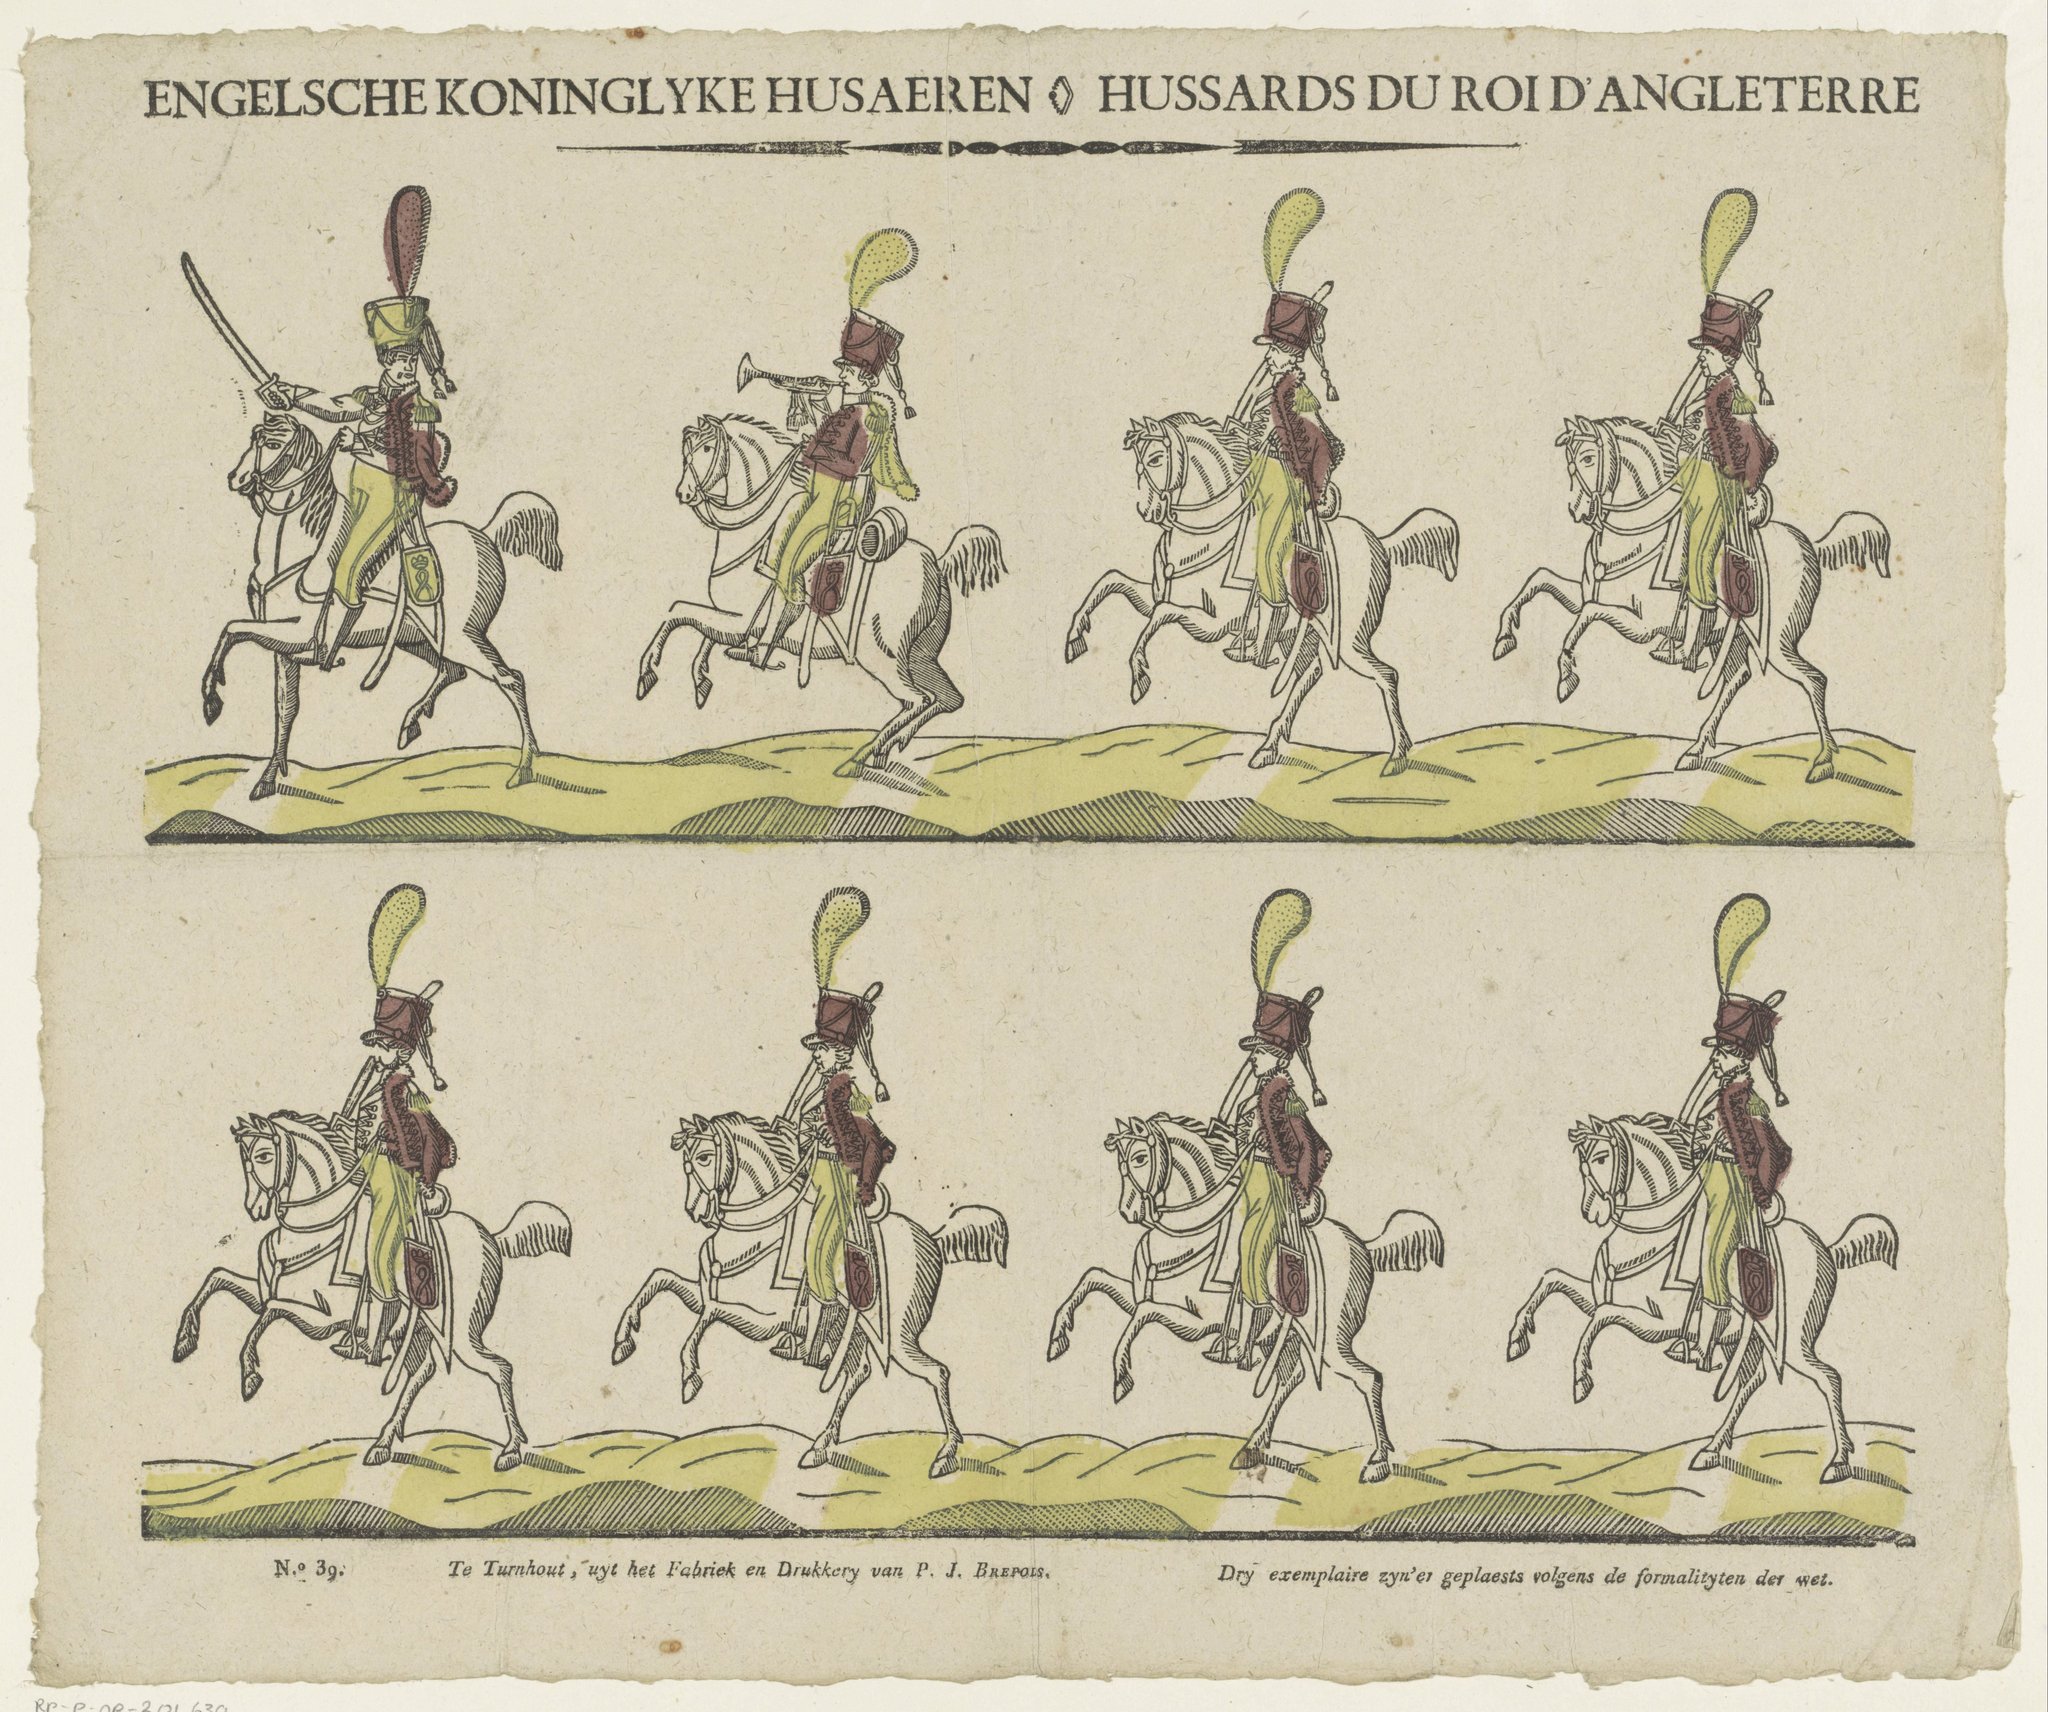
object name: print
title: Engelsche koniglyke Husaeren / Hussards du roi d'Angleterre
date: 1800-1833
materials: paper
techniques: colour, letterpress printing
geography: turnhout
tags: warfare; military affairs (+ cavalry, horsemen)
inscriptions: collector's mark: Lugt 2760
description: Blad met 2 horizontale rijen met elk vier Engelse militairen te paard. Genummerd linksonder: No. 39.